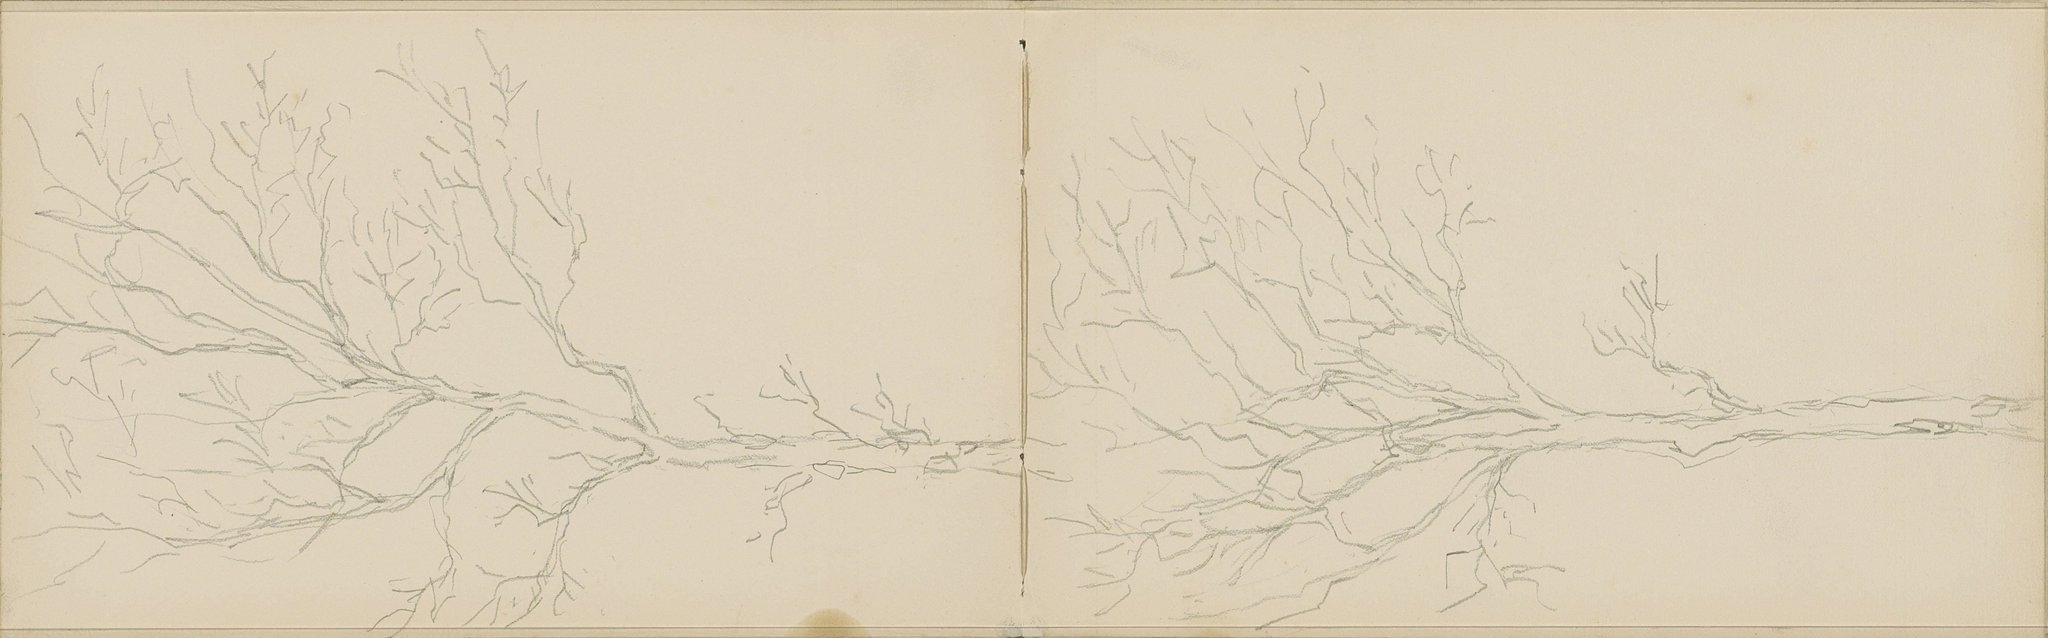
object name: sketchbook leaf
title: Bomen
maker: anna catharina maria van eeghen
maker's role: draughtsman, print maker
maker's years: 1878-1924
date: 1888-1901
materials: paper, pencil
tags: trees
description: Blad 1 verso en 2 recto uit een schetsboek met 33 bladen.